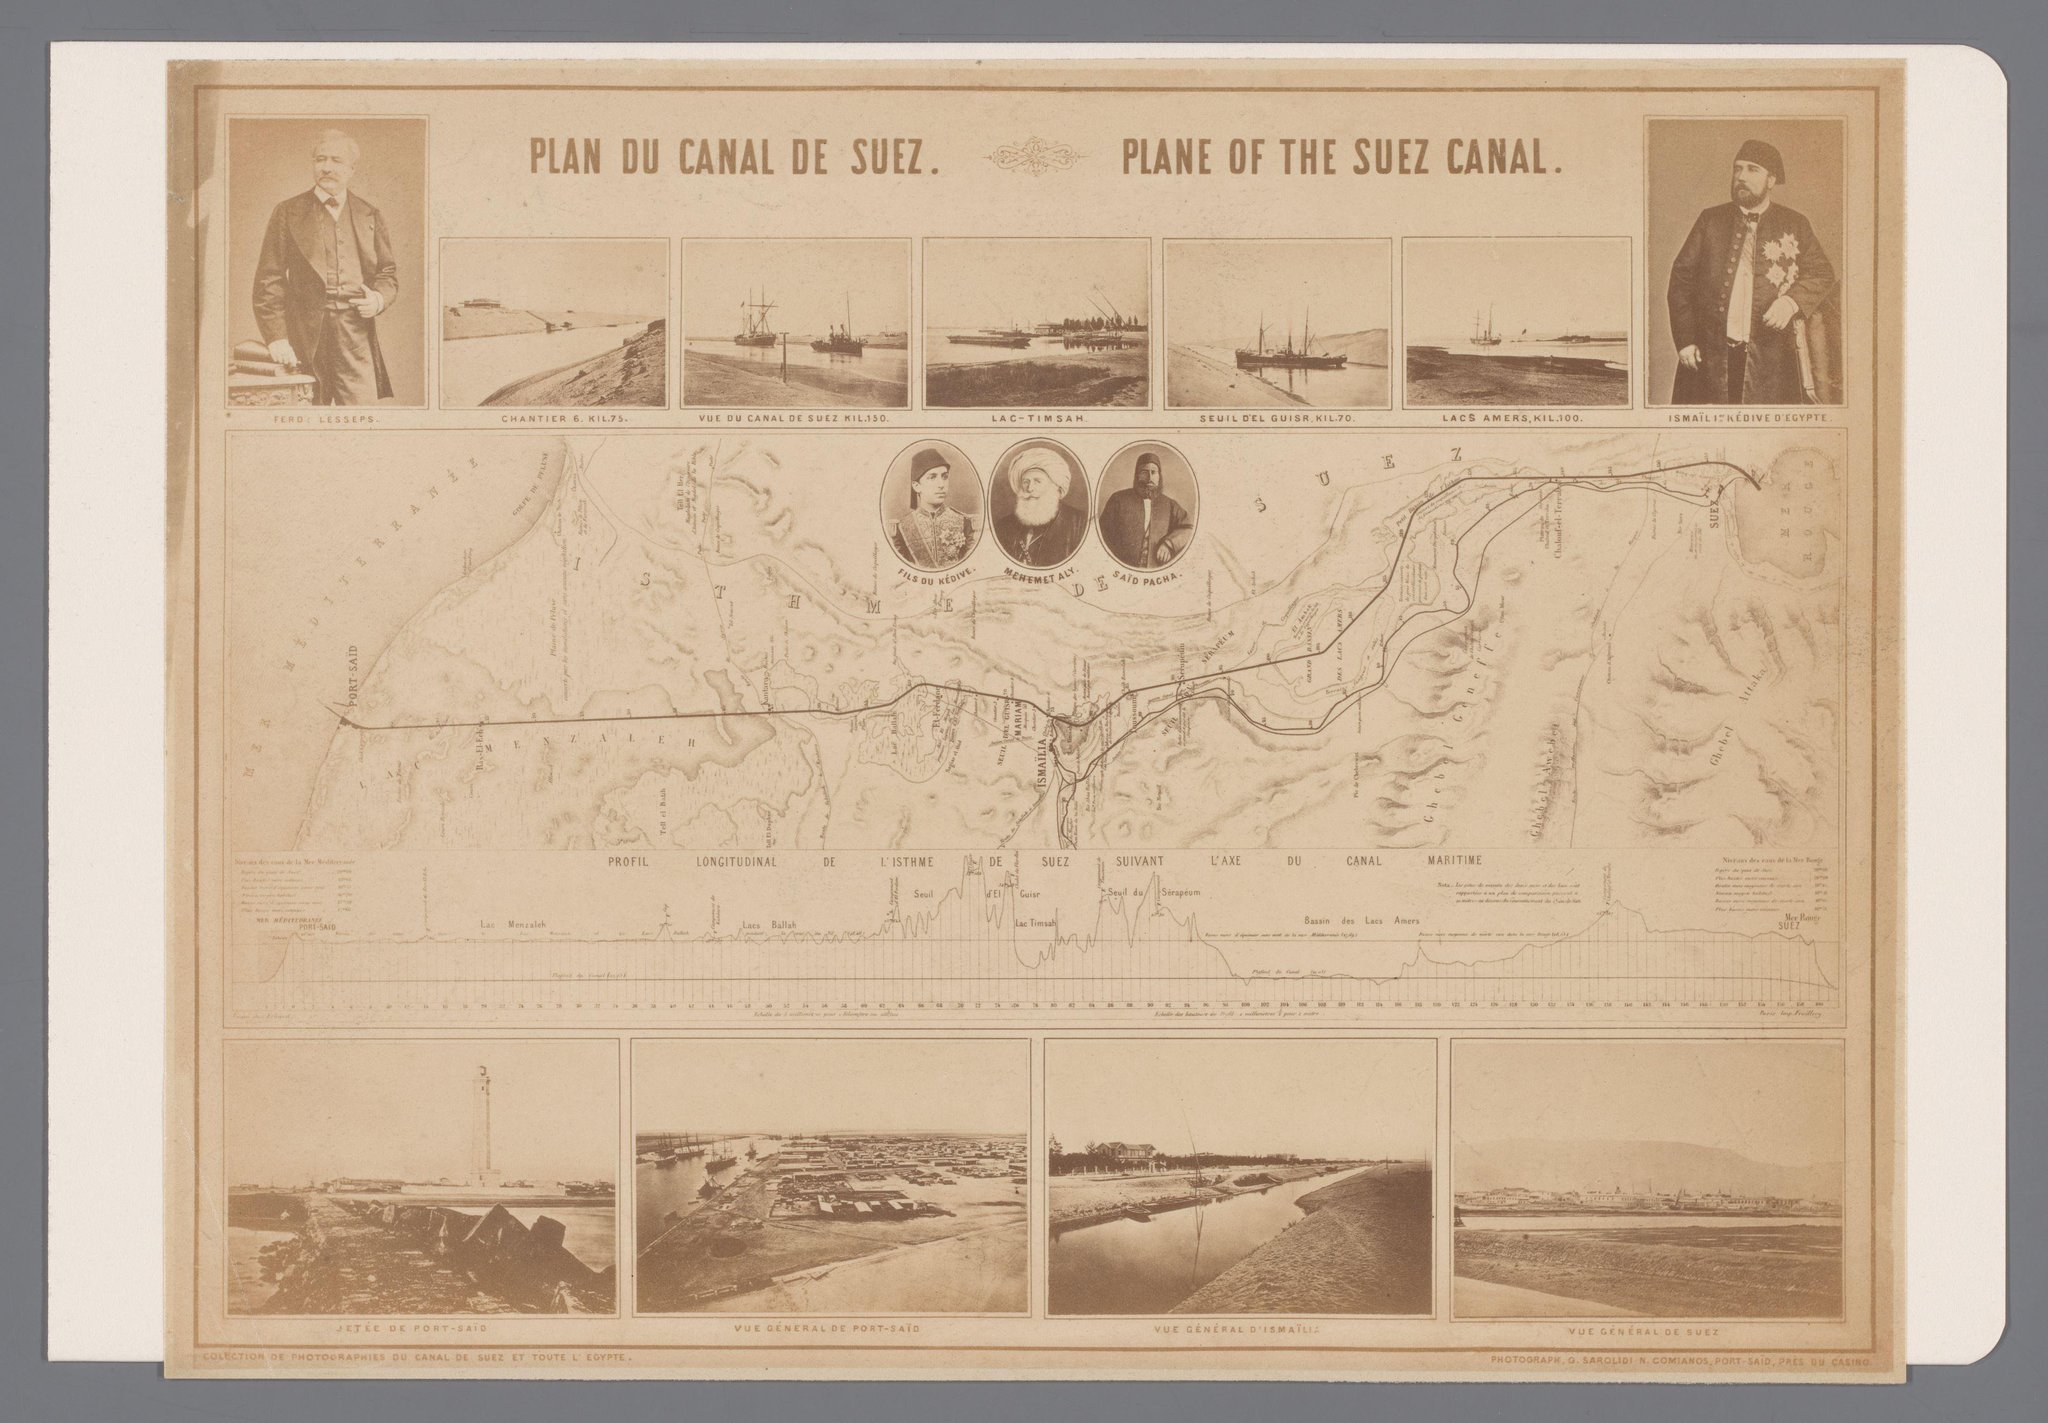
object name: photograph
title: Collection de photographies de Canal de Suez et toute l'Egypte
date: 1870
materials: paper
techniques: albumen print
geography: egypt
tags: france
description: Plattegrond van het Suezkanaal omringd door gezichten op Suez, Ismaïlia en Port Said, en portretten van Ferdinand de Lesseps, Ismaïl Pasha, Tewfik Pasha, Mohammed Ali van Egypte en Said van Egypte.